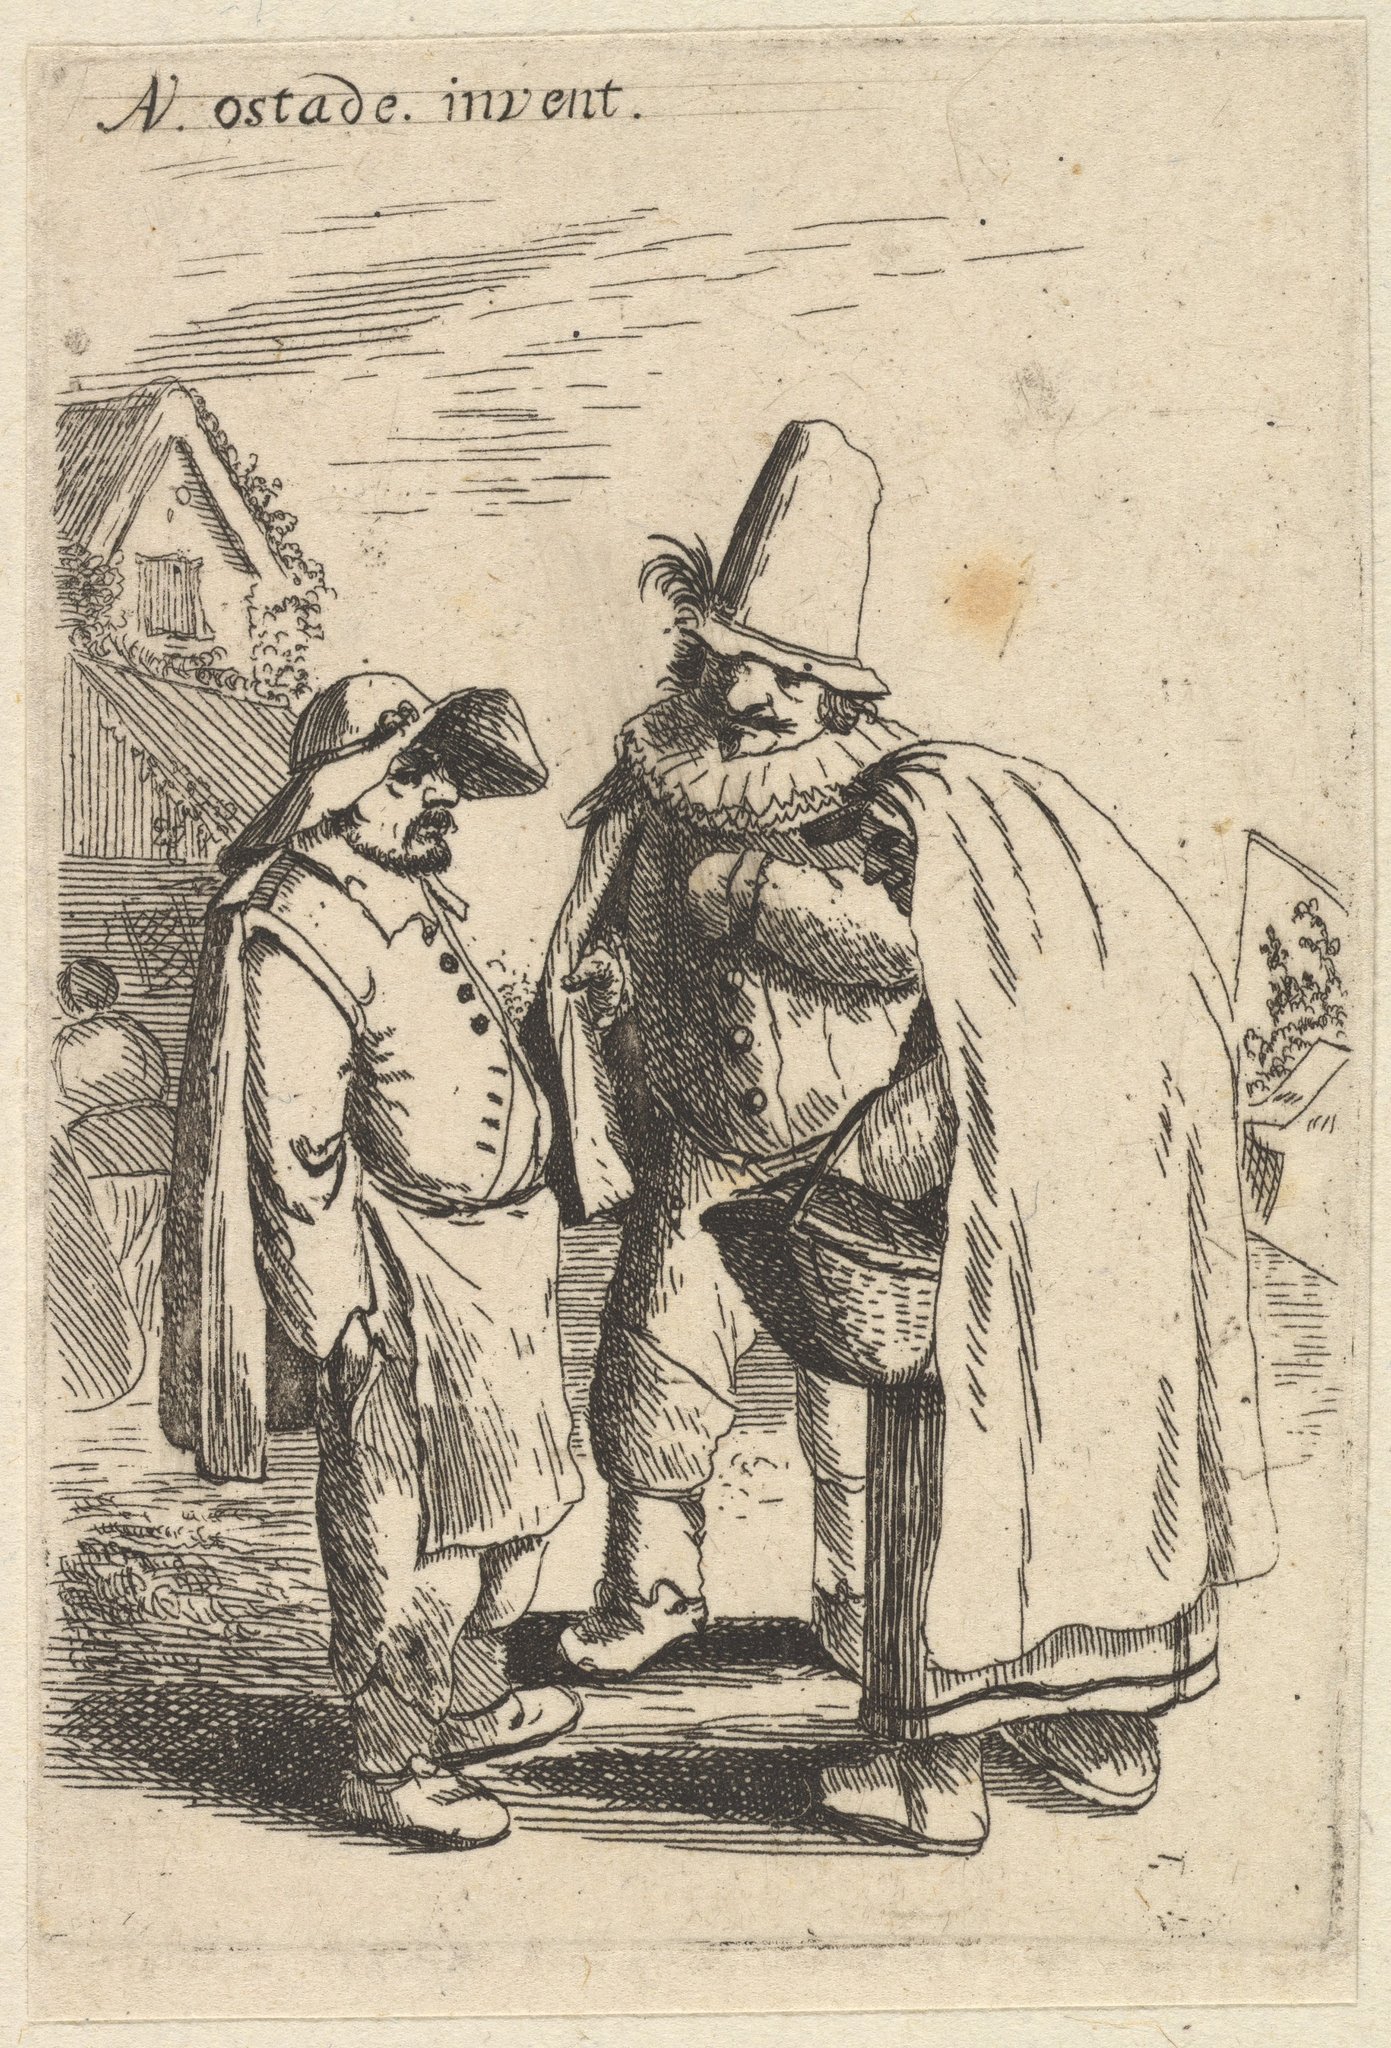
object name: print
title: Grotesque Figures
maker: adriaen van ostade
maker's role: artist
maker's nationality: dutch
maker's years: 1610-1685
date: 1610-1685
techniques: etching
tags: men